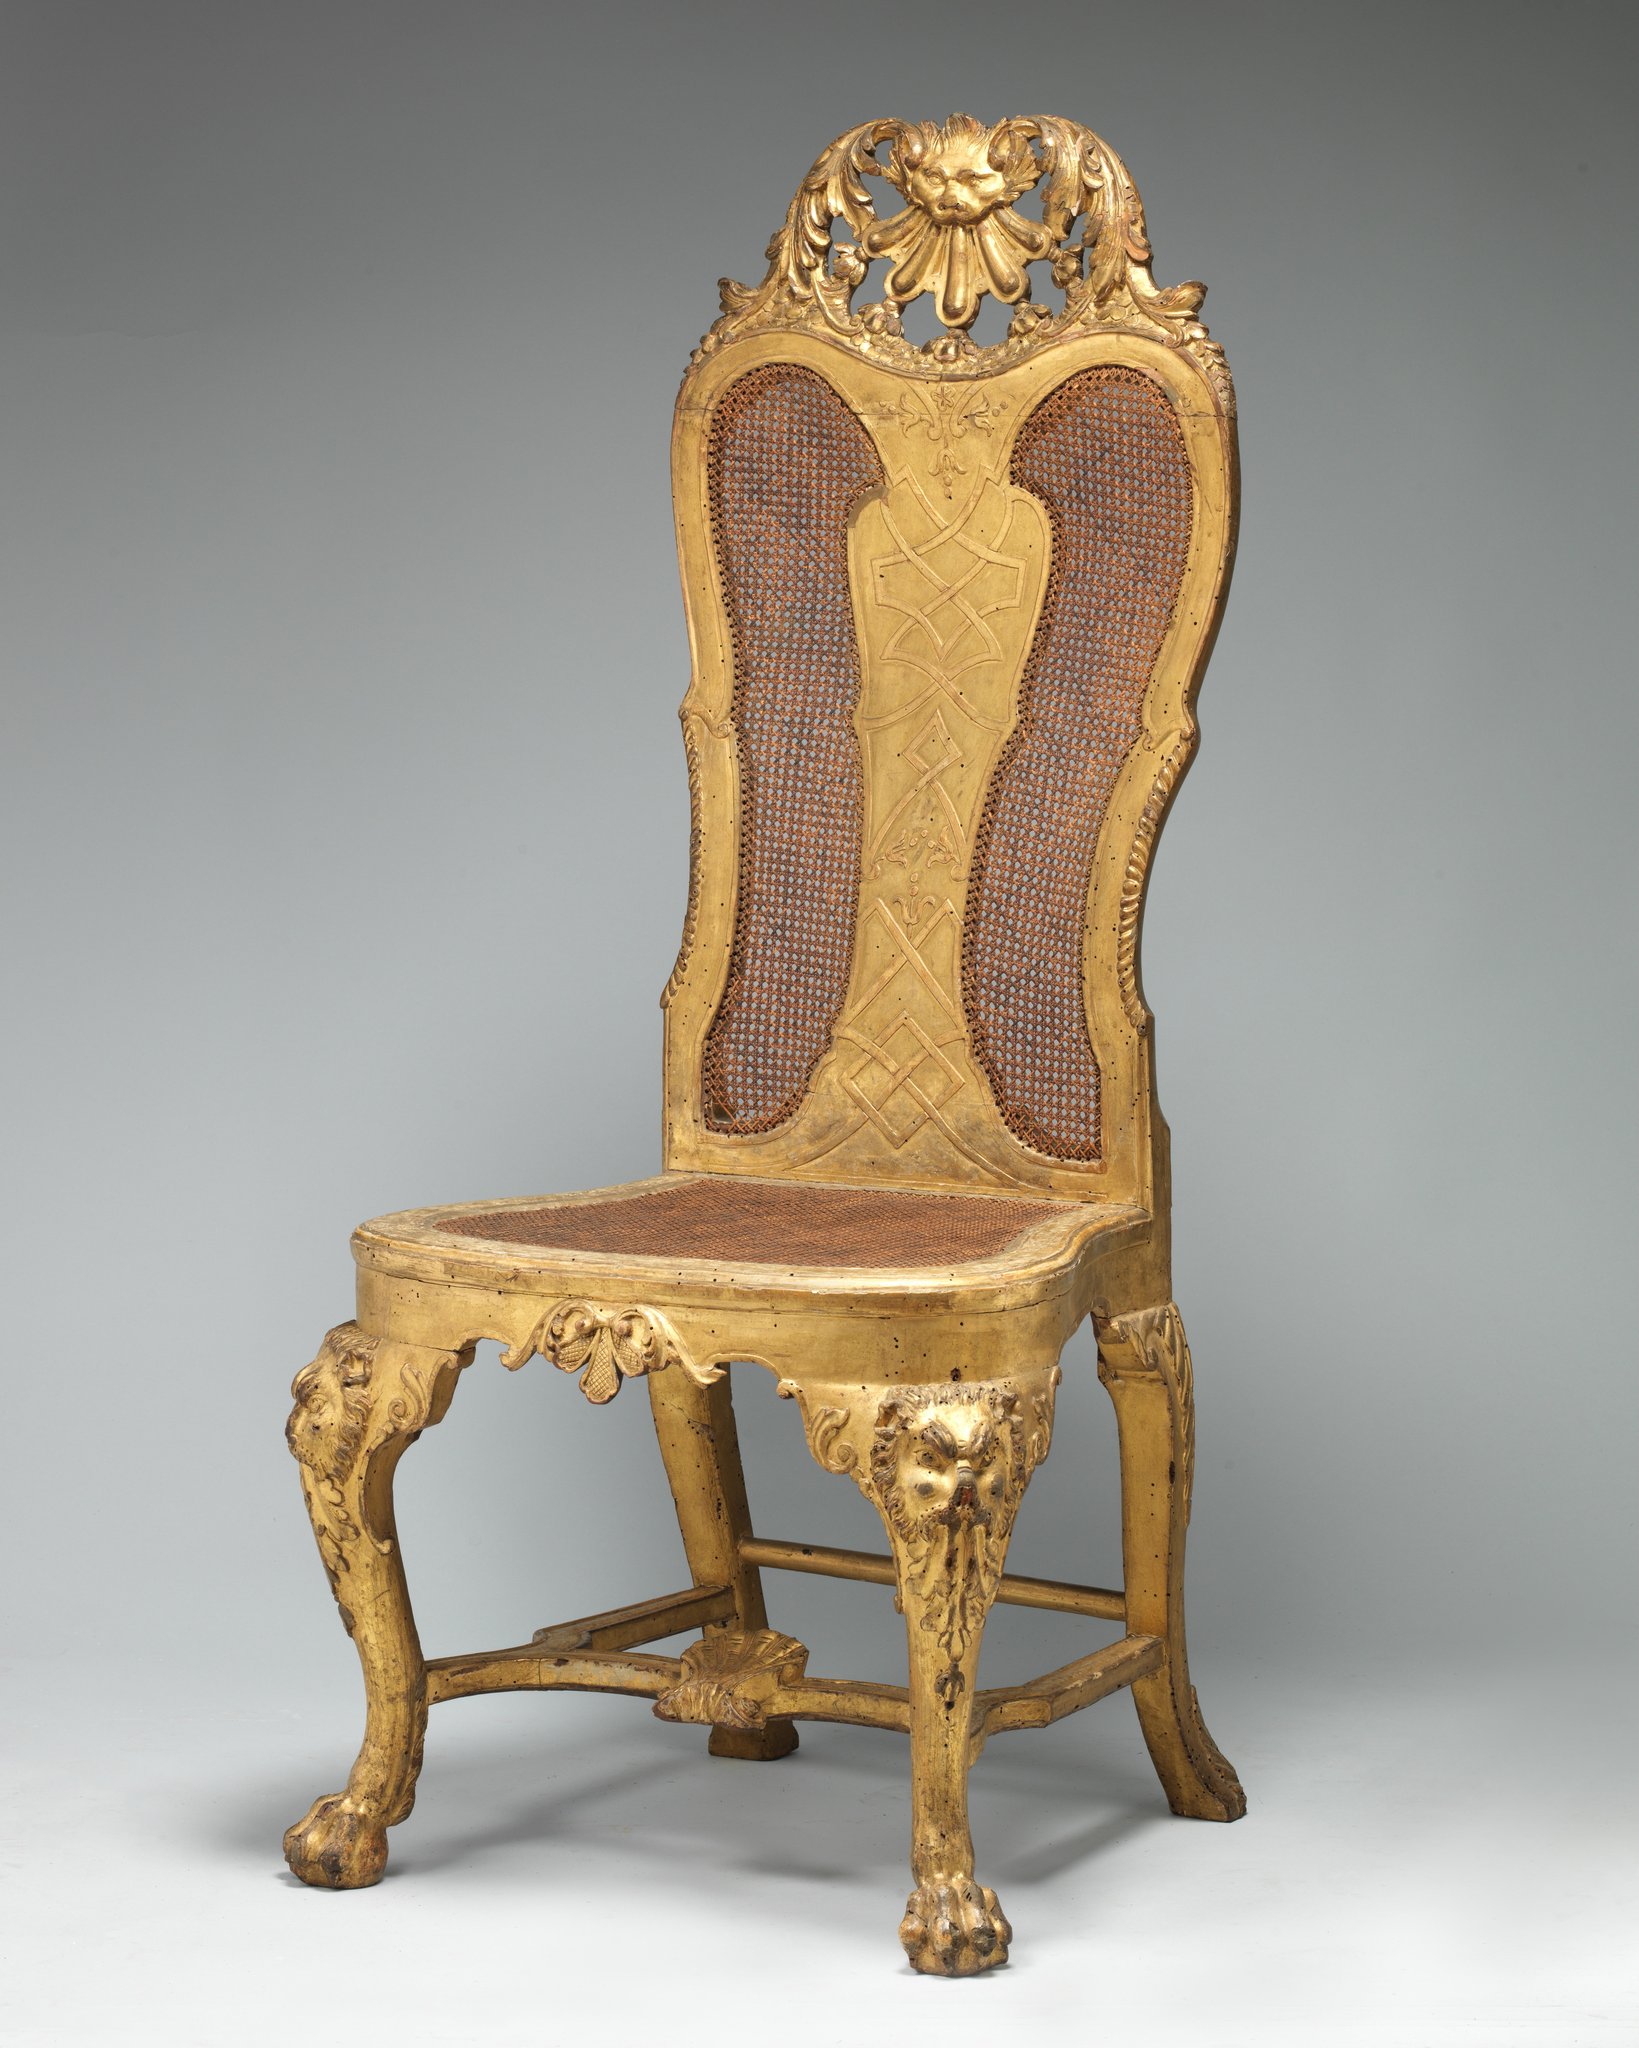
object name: side chair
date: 1720-1730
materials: wood